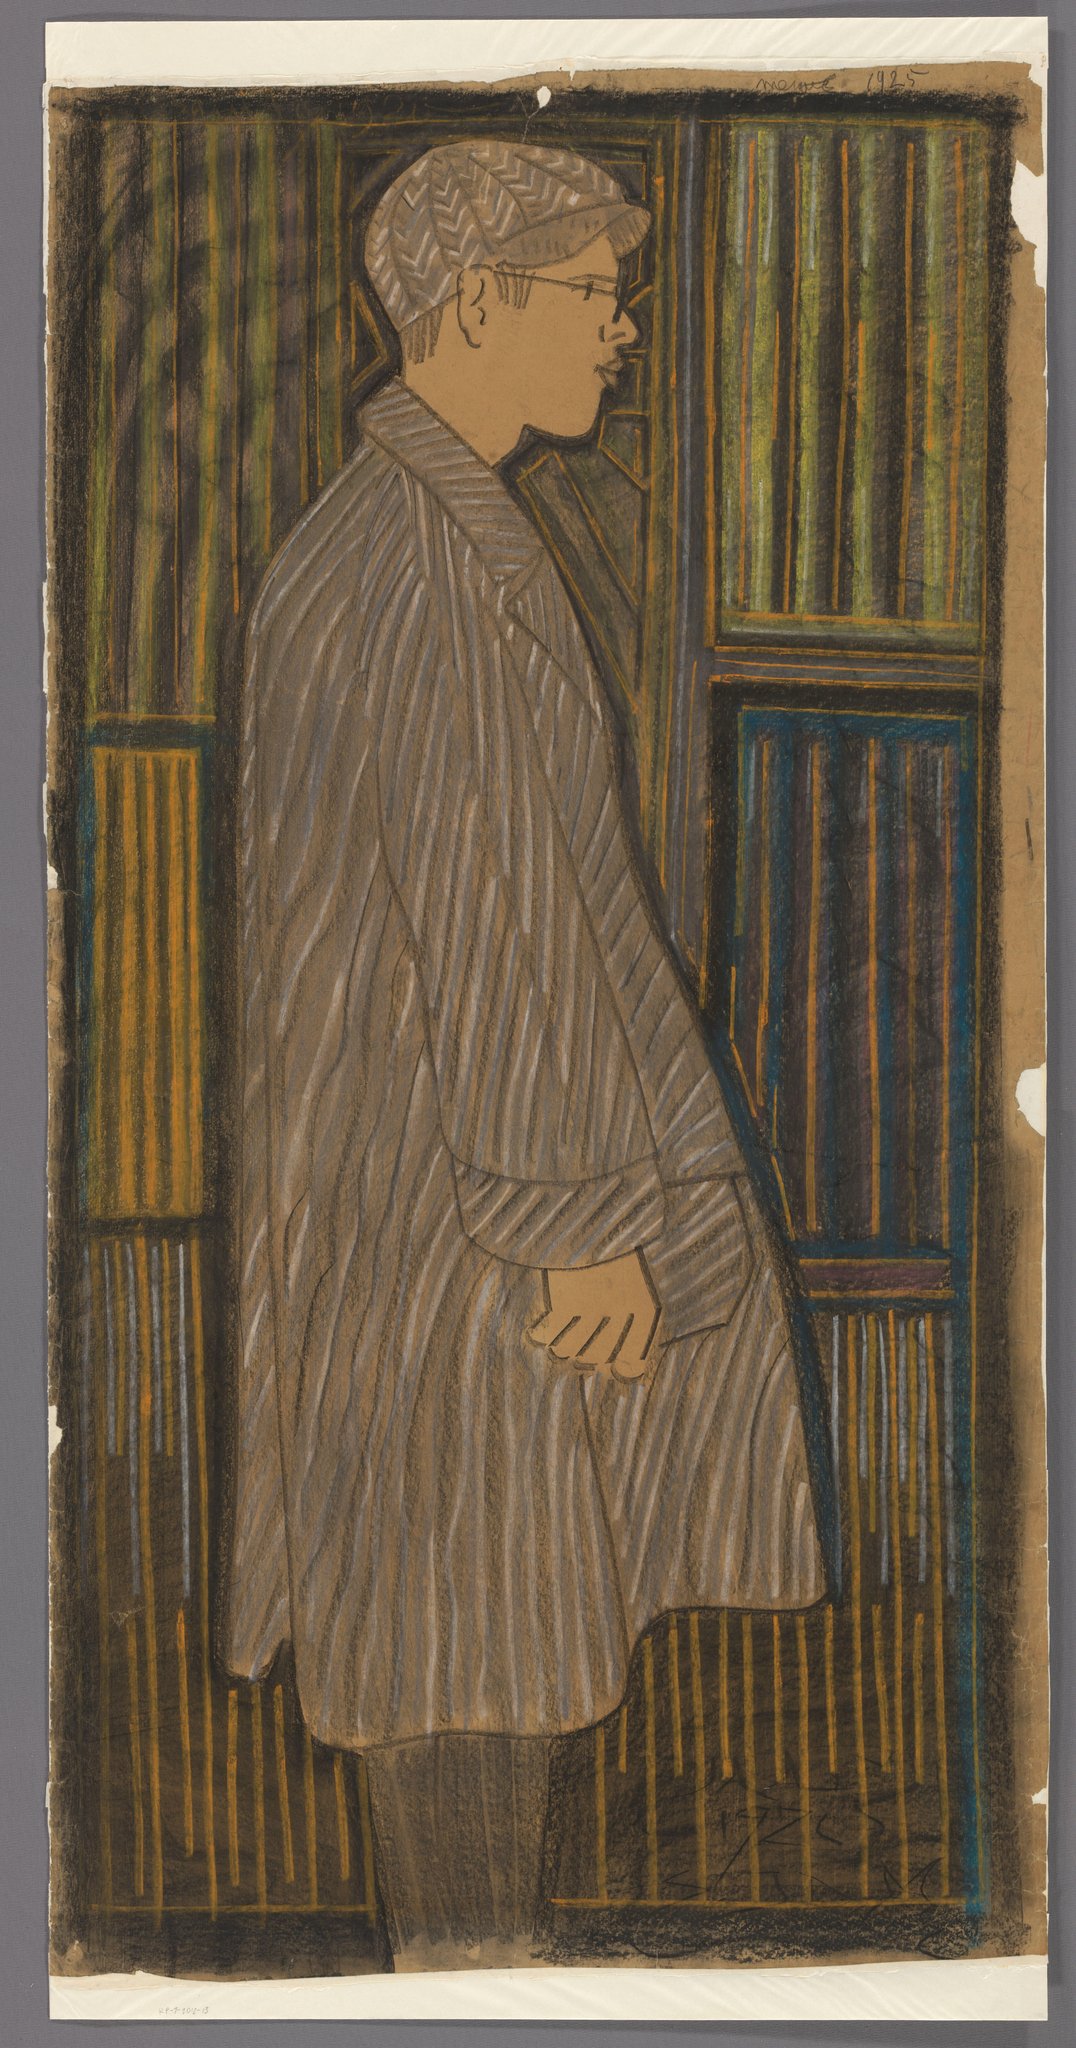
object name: drawing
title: Staande jongen ten voeten uit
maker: samuel jessurun de mesquita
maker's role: draughtsman, print maker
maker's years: 1868-1944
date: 1925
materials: chalk, paper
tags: standing or leaning with both legs straight, side by side, feet flat on the ground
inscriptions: signature and date: ‘mesquita 1921’, number: ‘OB6675 Cat.12’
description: Staande jongen ten voeten uit met bril en pet, tegen een decoratieve achtergrond bestaande uit strepen in verschillende richtingen.